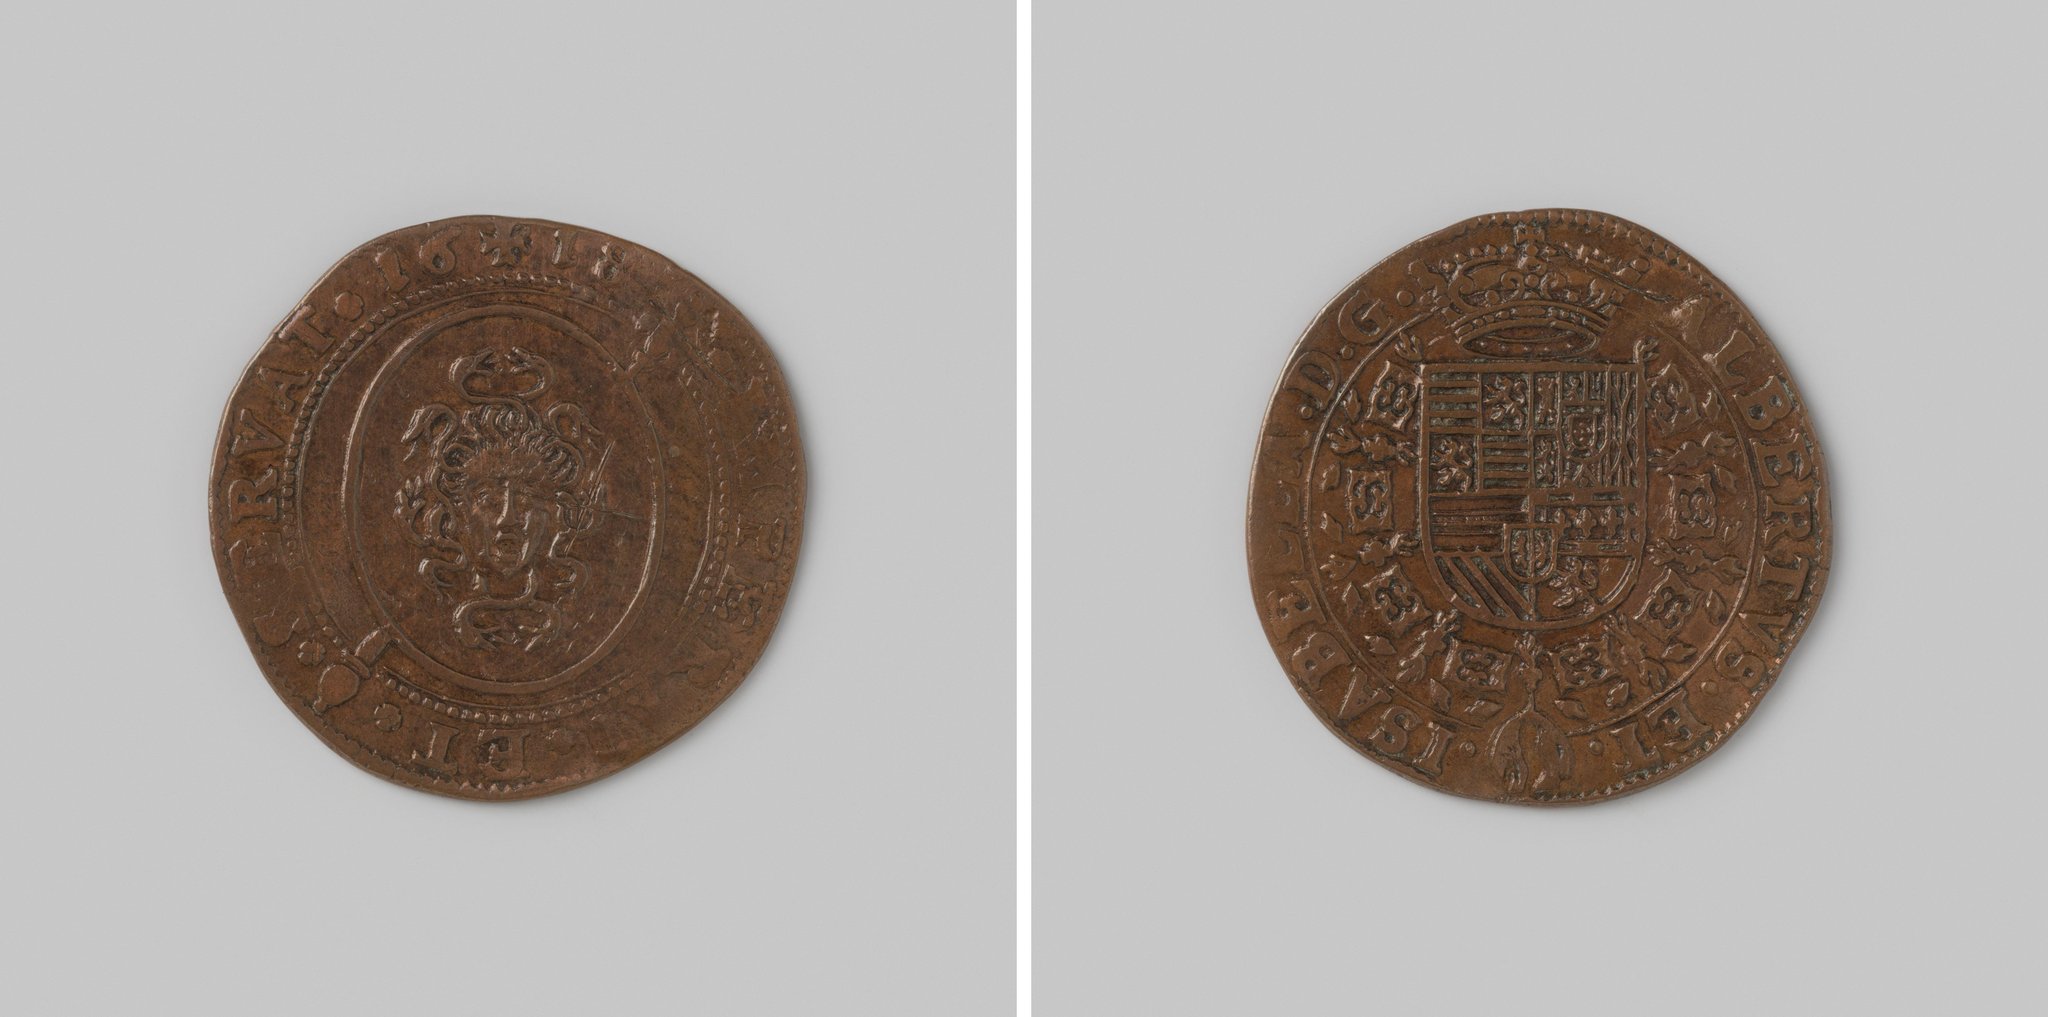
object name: jeton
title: Rekenpenning op naam van de Aartshertogen 1618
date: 1618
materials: copper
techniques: striking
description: Koperen penning, op de voorzijde een ovaal schild met medusahoofd waarachter een scepter, met omschrift, op de keerzijde het gekroonde Spaanse wapenschild omhangen met de keten van het Gulden Vlies, met omschrift.